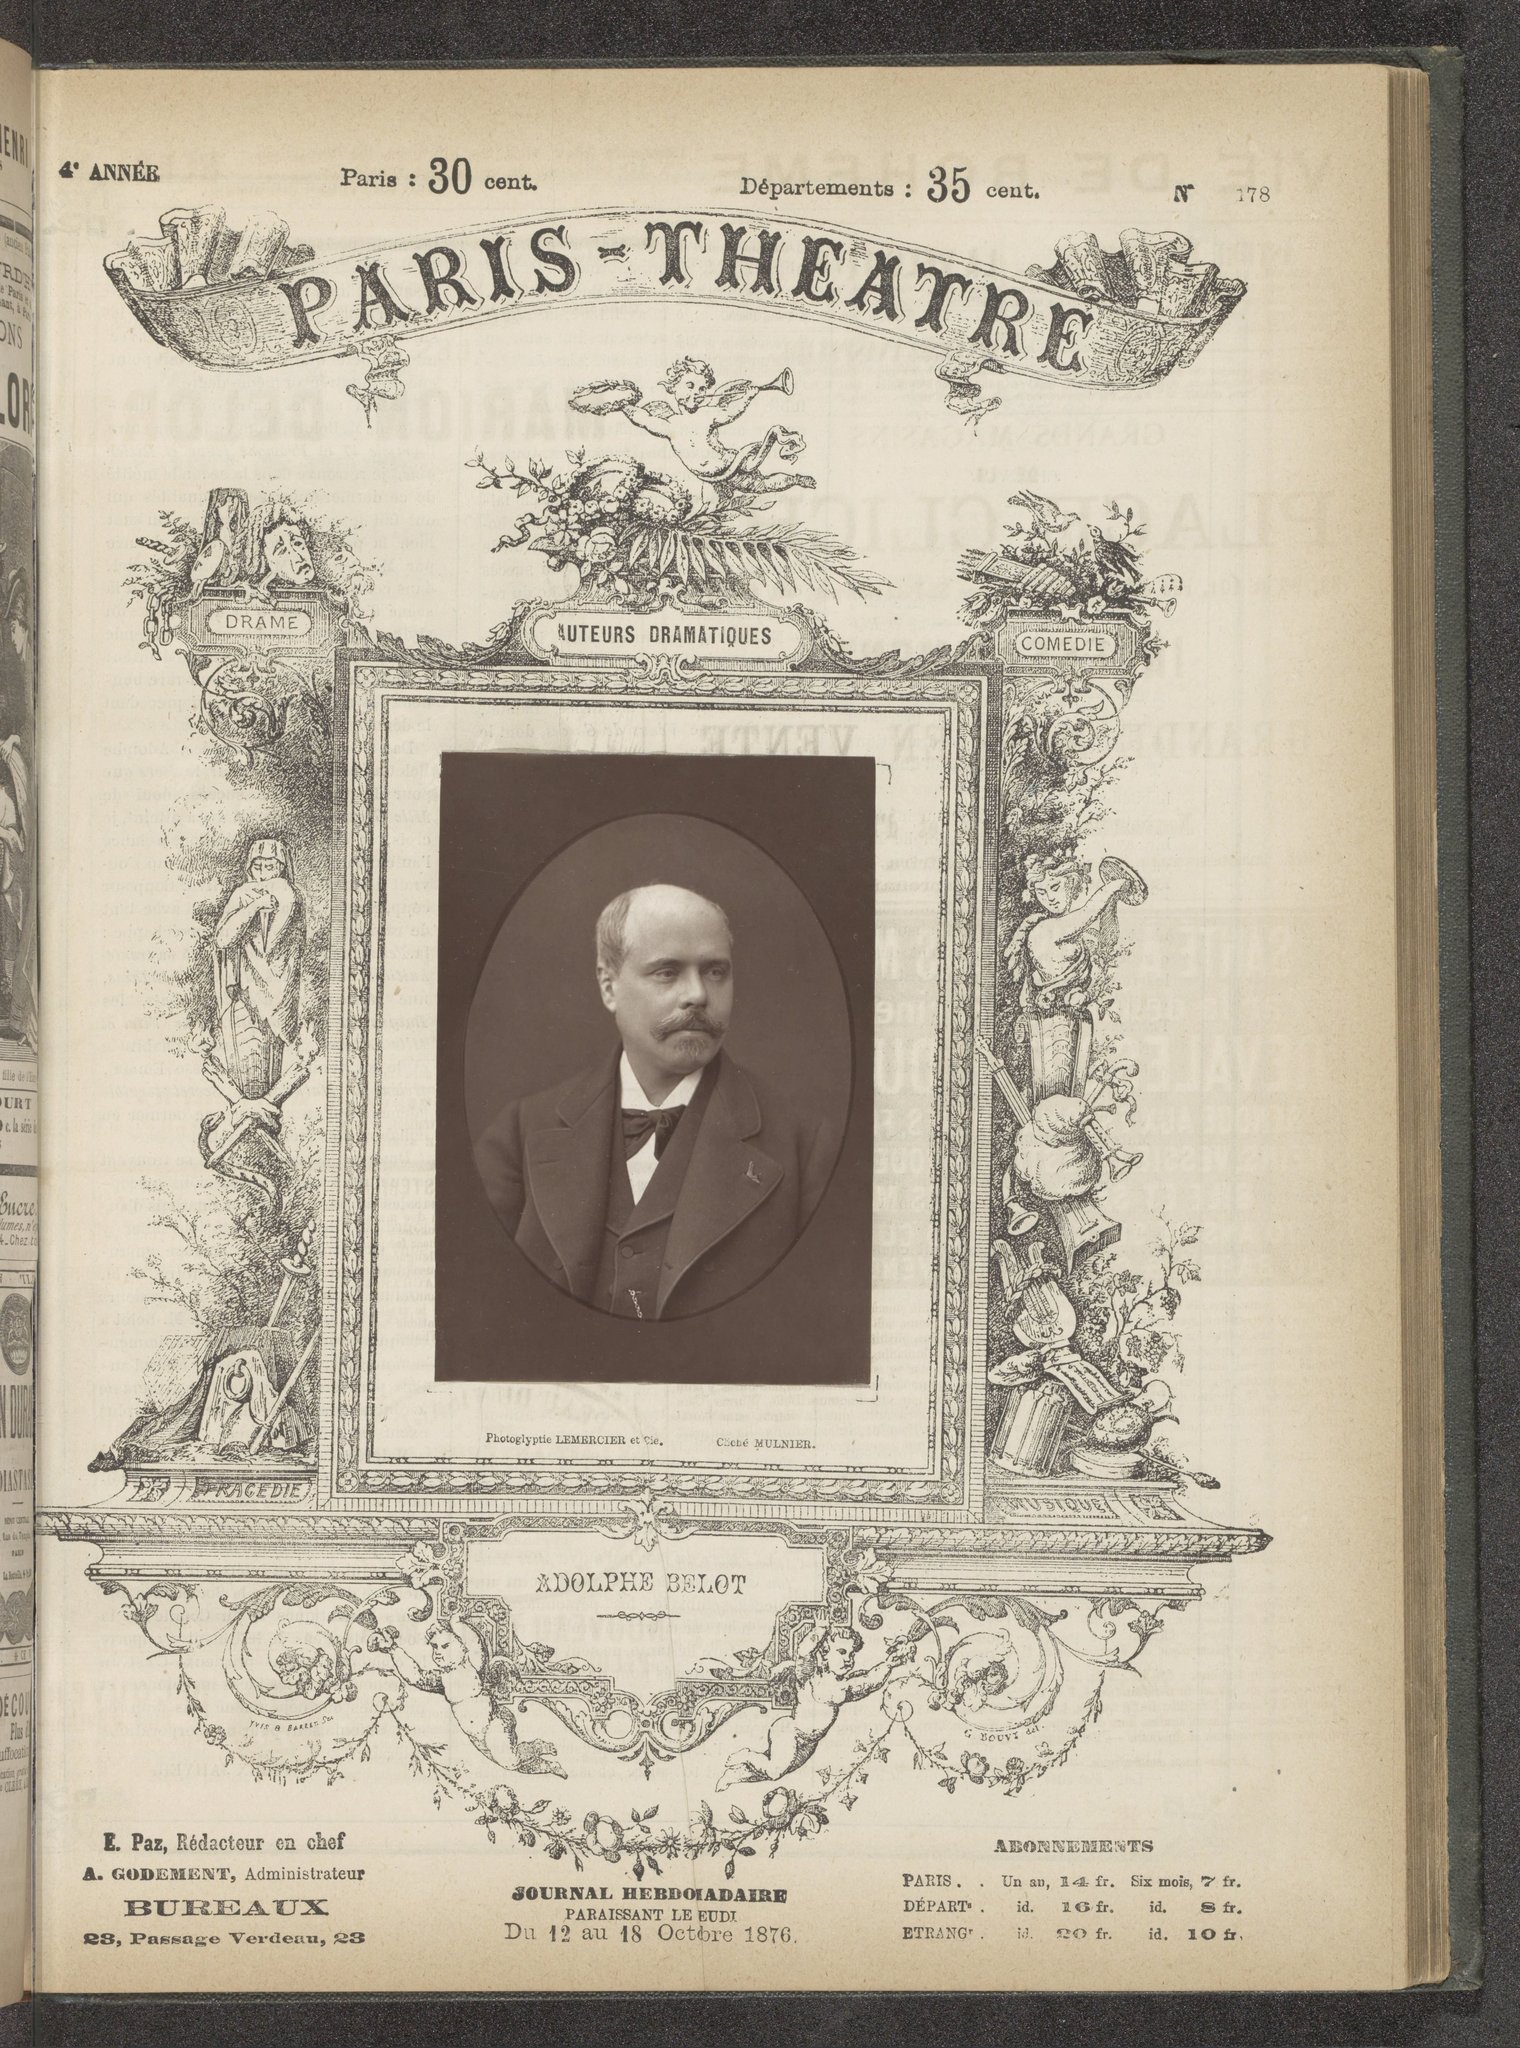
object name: page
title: Adolphe Belot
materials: paper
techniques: woodburytype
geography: france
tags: writer, poet, author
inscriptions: inscription: ‘Journal hebdomadaire paraissant le jeudi Du 12 au 18 Octobre 1876’, number: ‘No 178’